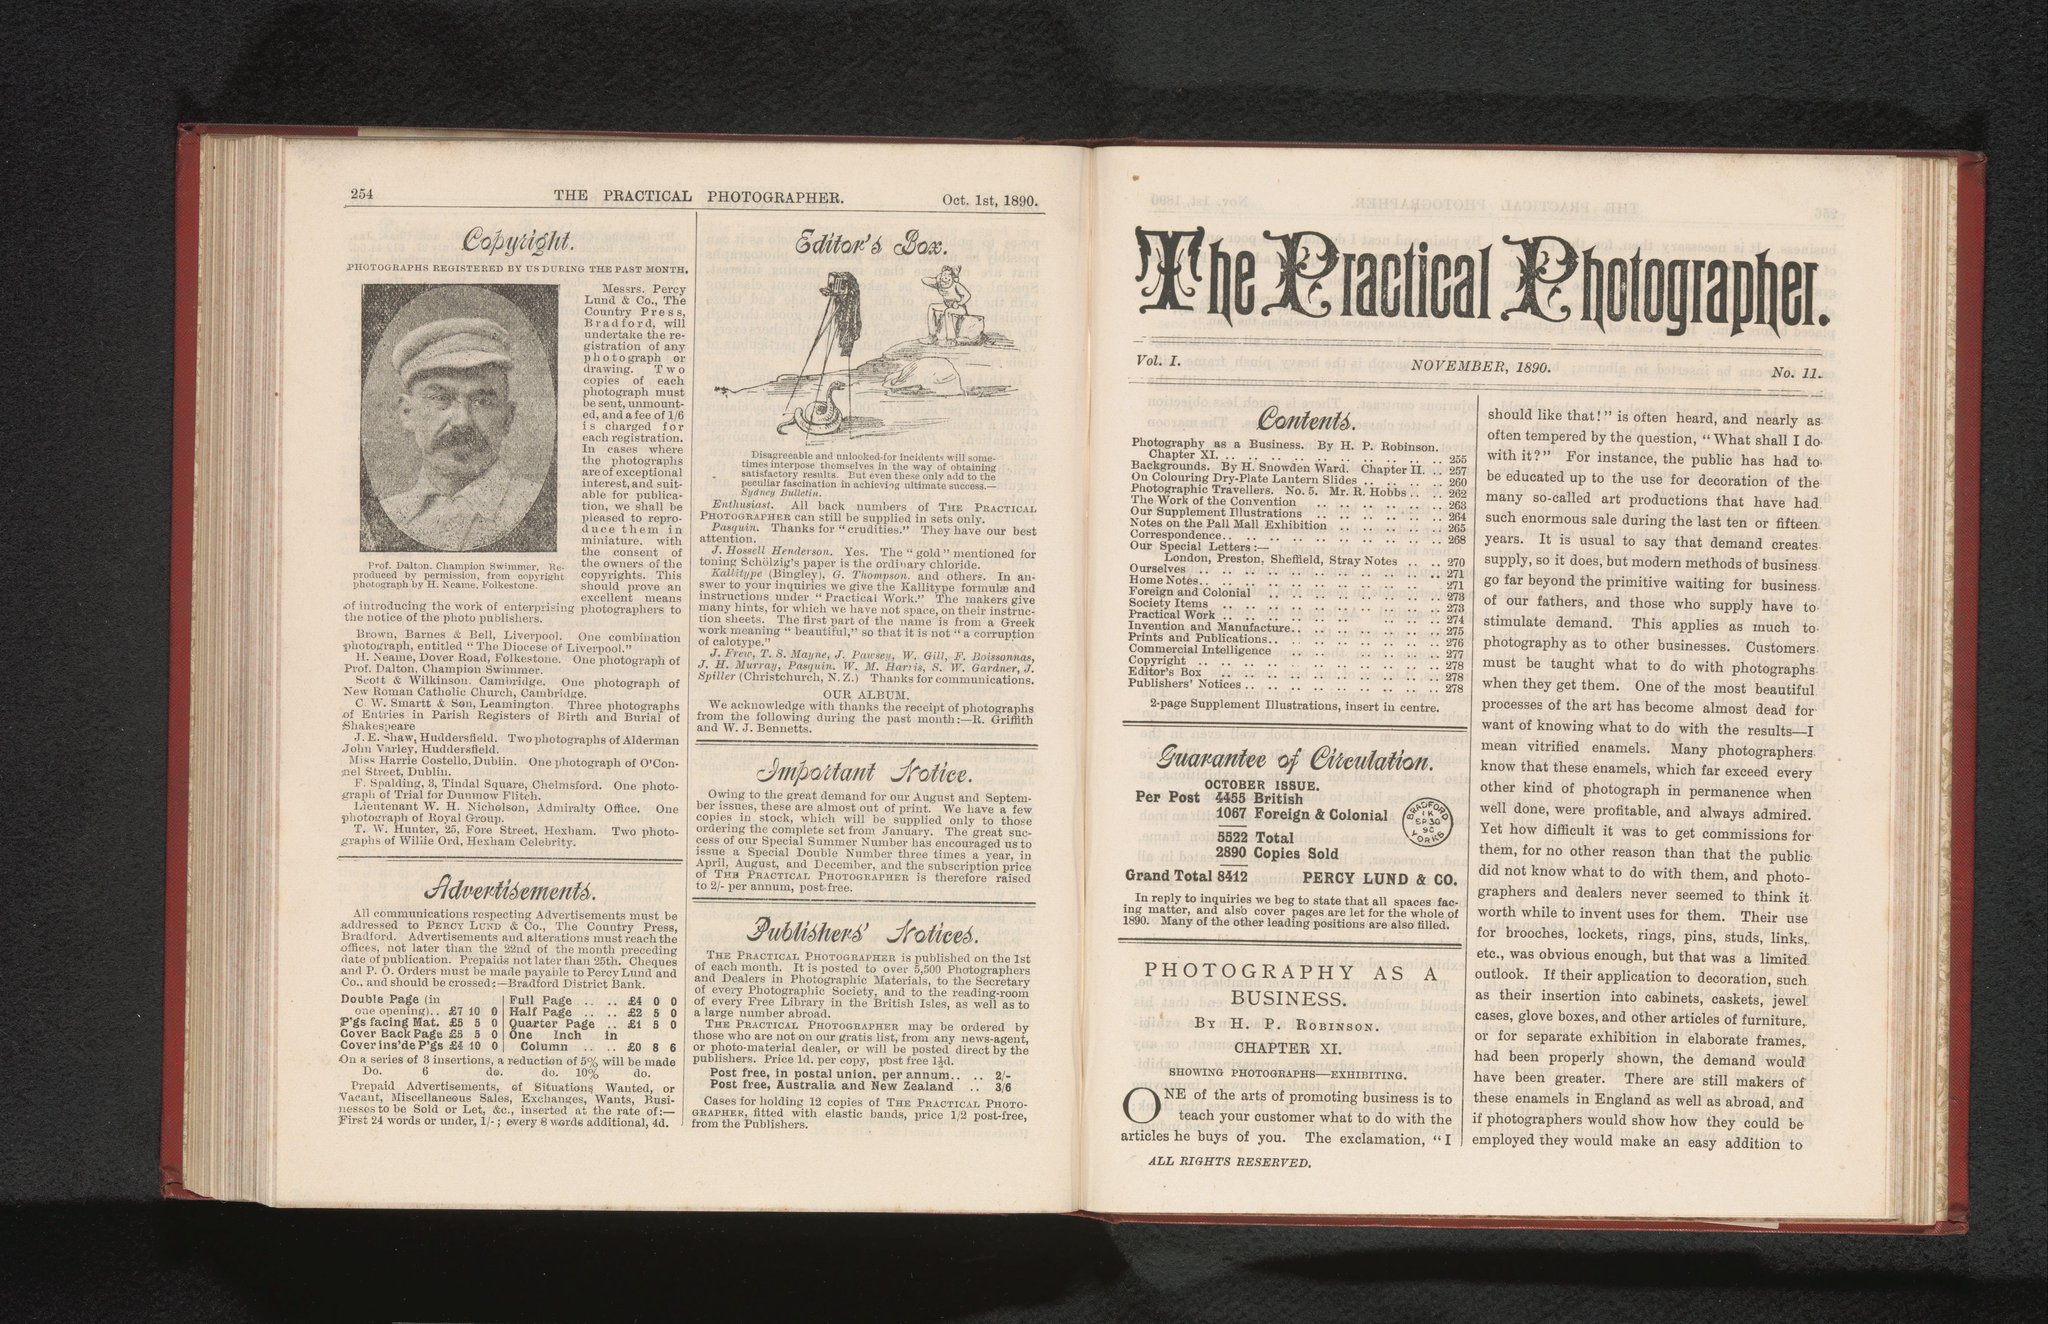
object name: page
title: Portret van een onbekende man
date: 1885-1890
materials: paper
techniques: autotype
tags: historical persons not known by name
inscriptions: inscription: ‘Prof. Dalton. Champion Swimmer, Re-/ produced by permission, from copyright/ photograph by H. Neame, Folkestone.’